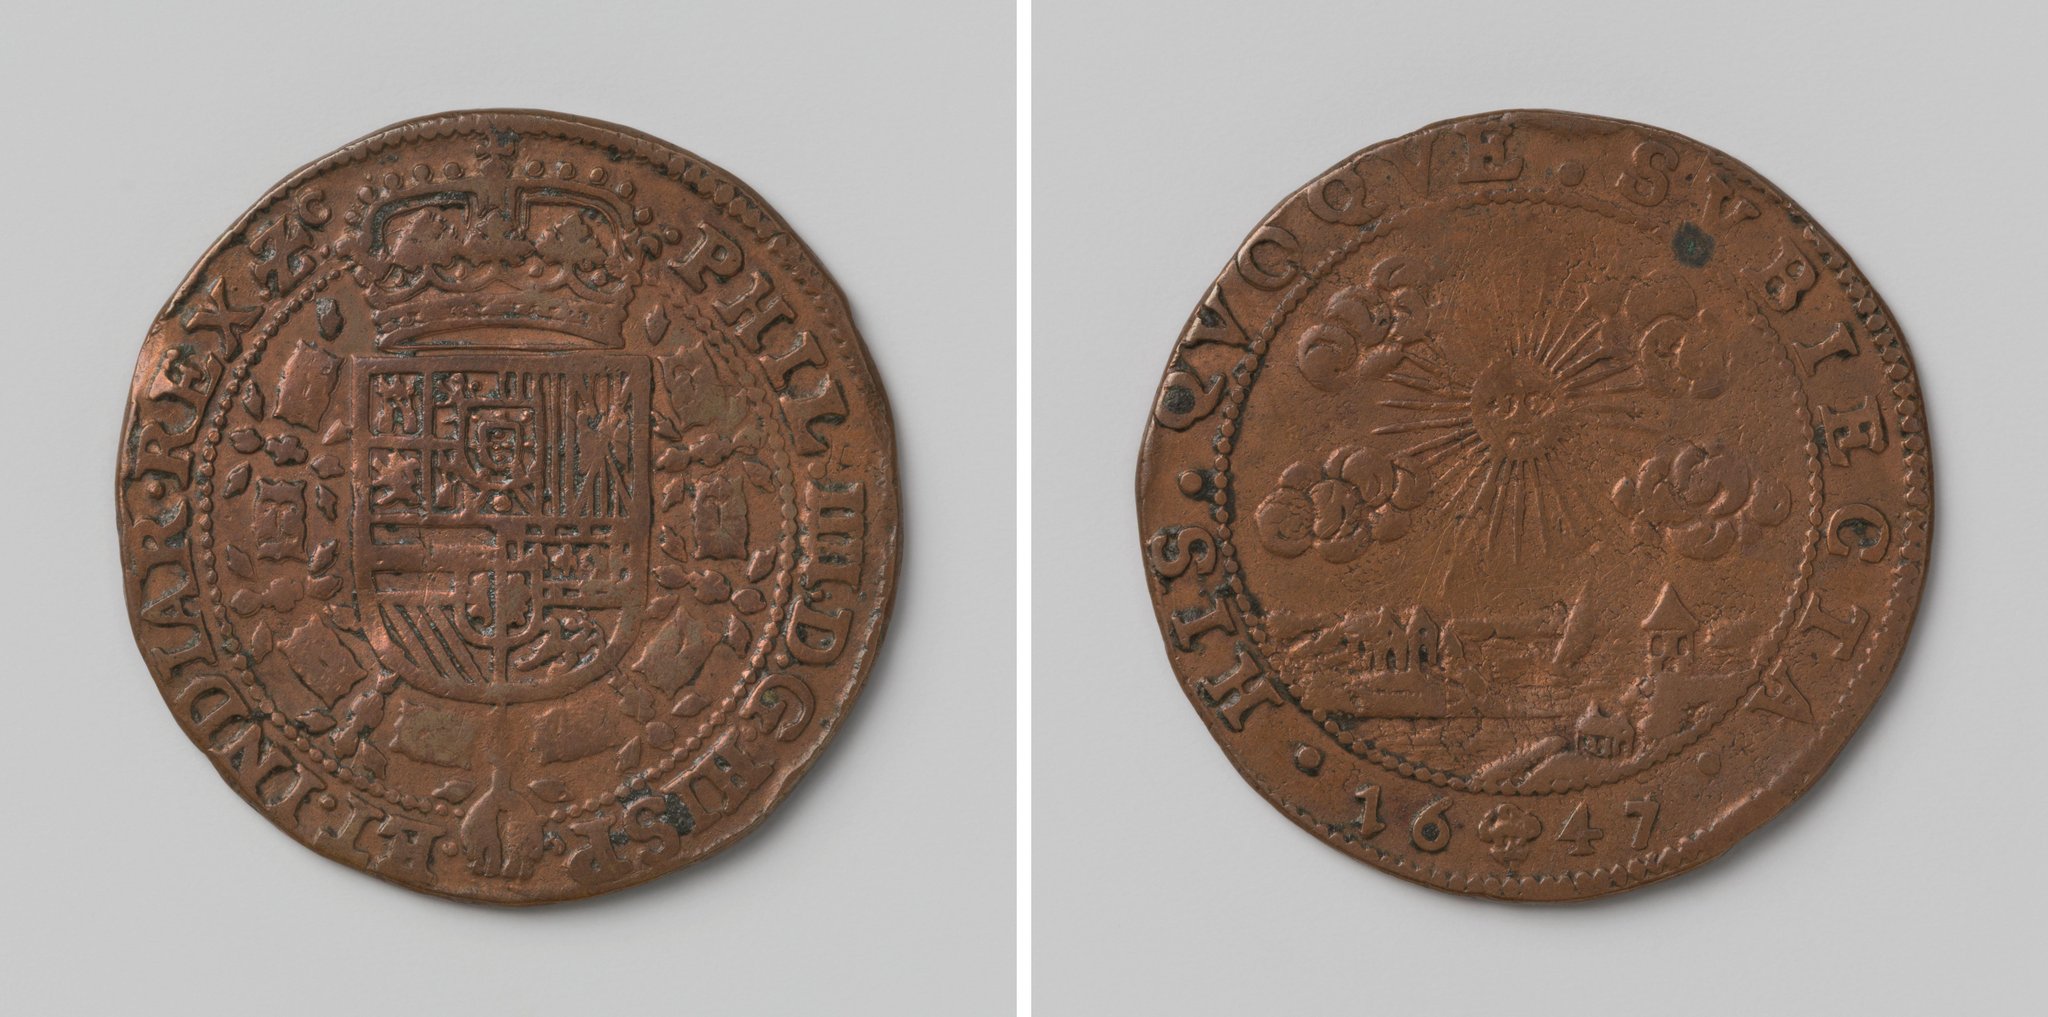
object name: jeton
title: Filips IV, koning van Spanje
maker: Anonymous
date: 1647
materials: copper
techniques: striking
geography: brussels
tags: filips iv (koning van spanje)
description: Koperen penning. Voorzijde: gekroond wapenschild, omhangen met de orde van het Gulden Vlies binnen omschrift. Keerzijde: stralende zon, omgeven door wolken boven haven binnen omschrift